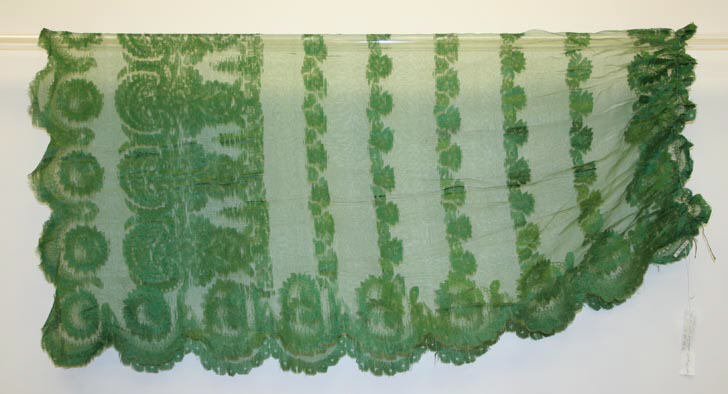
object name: veil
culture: indian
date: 1844